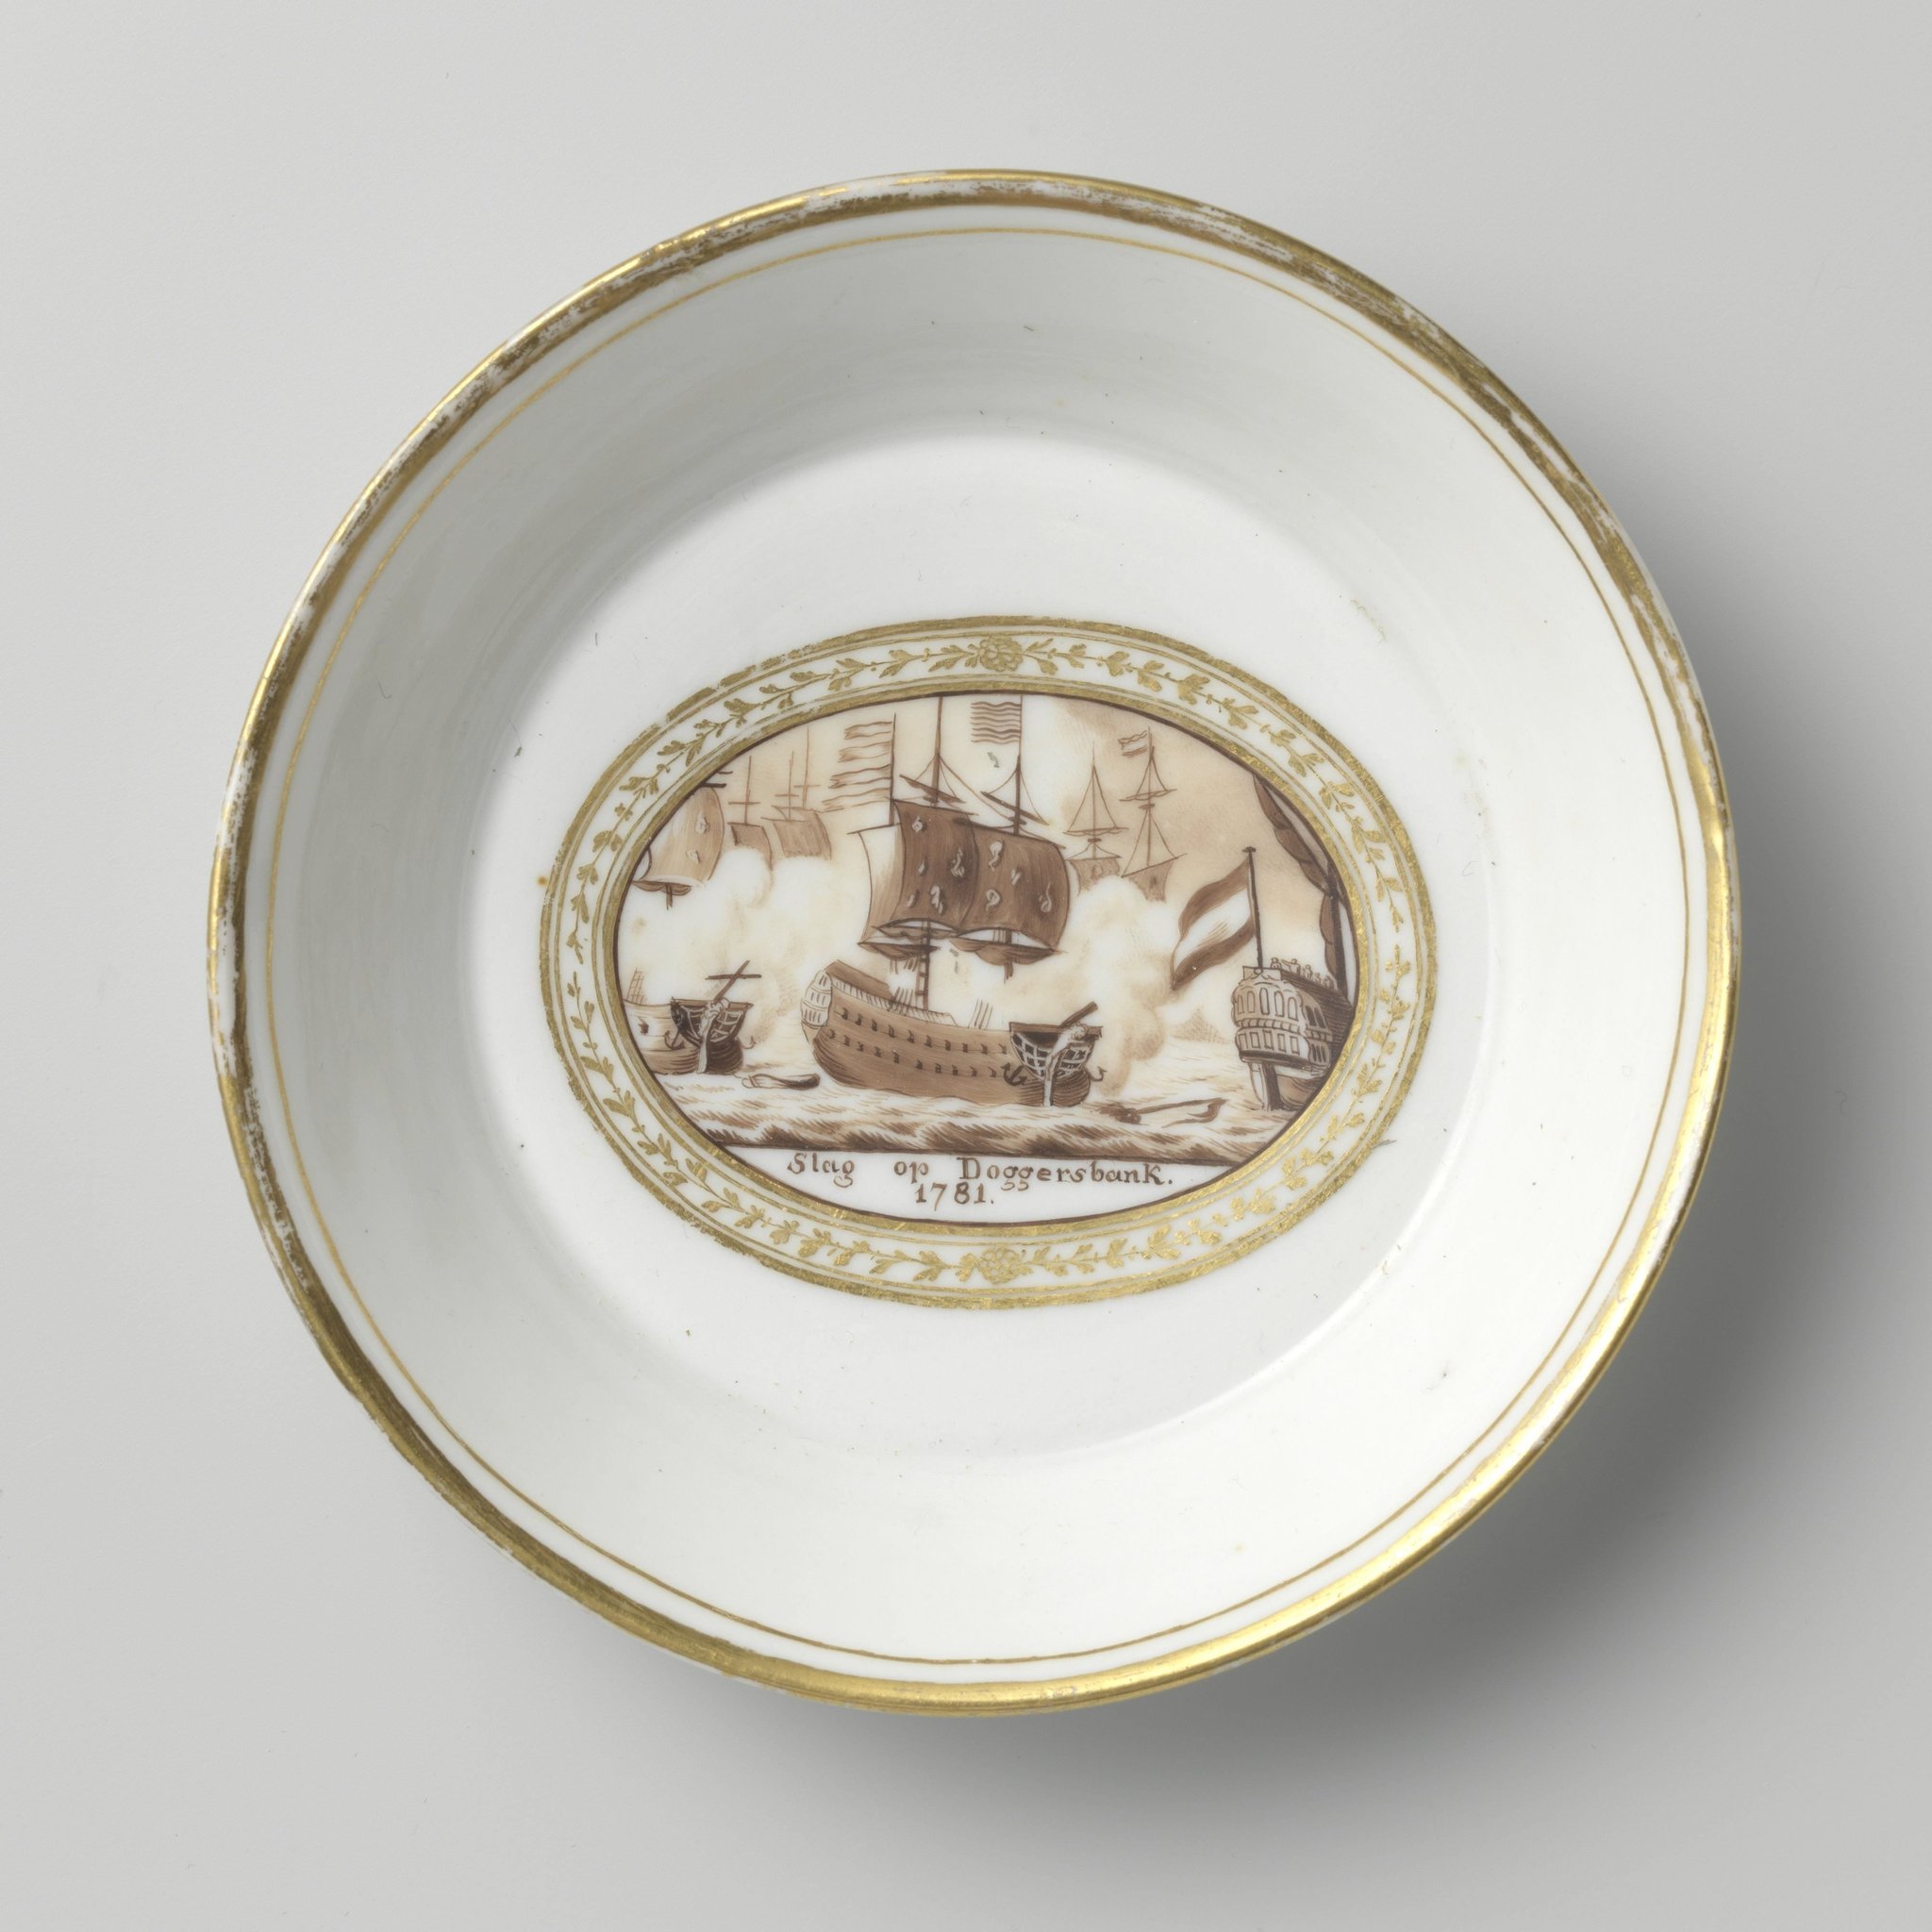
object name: service set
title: Saucer with an image of the Battle of Doggersbank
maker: Anonymous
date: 1794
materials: glaze, gold, paint, porcelain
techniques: firing, forming, gilding, turning, vitrification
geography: ilmenau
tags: zeeslag bij doggersbank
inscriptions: mark: ‘103-N/ 6’, inscription: ‘SLAG OP DOGGERSBANK. 1781’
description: Schotel,één van een serie van tien,onderdeel van een servies met in bruin geschilderde medaillons waarin historische voorvallen en portretten van personen uit de vaderlandse geschiedenis. De schotel is gedecoreerd met een voorstelling van de Slag bij de Doggersbank. Gemerkt.